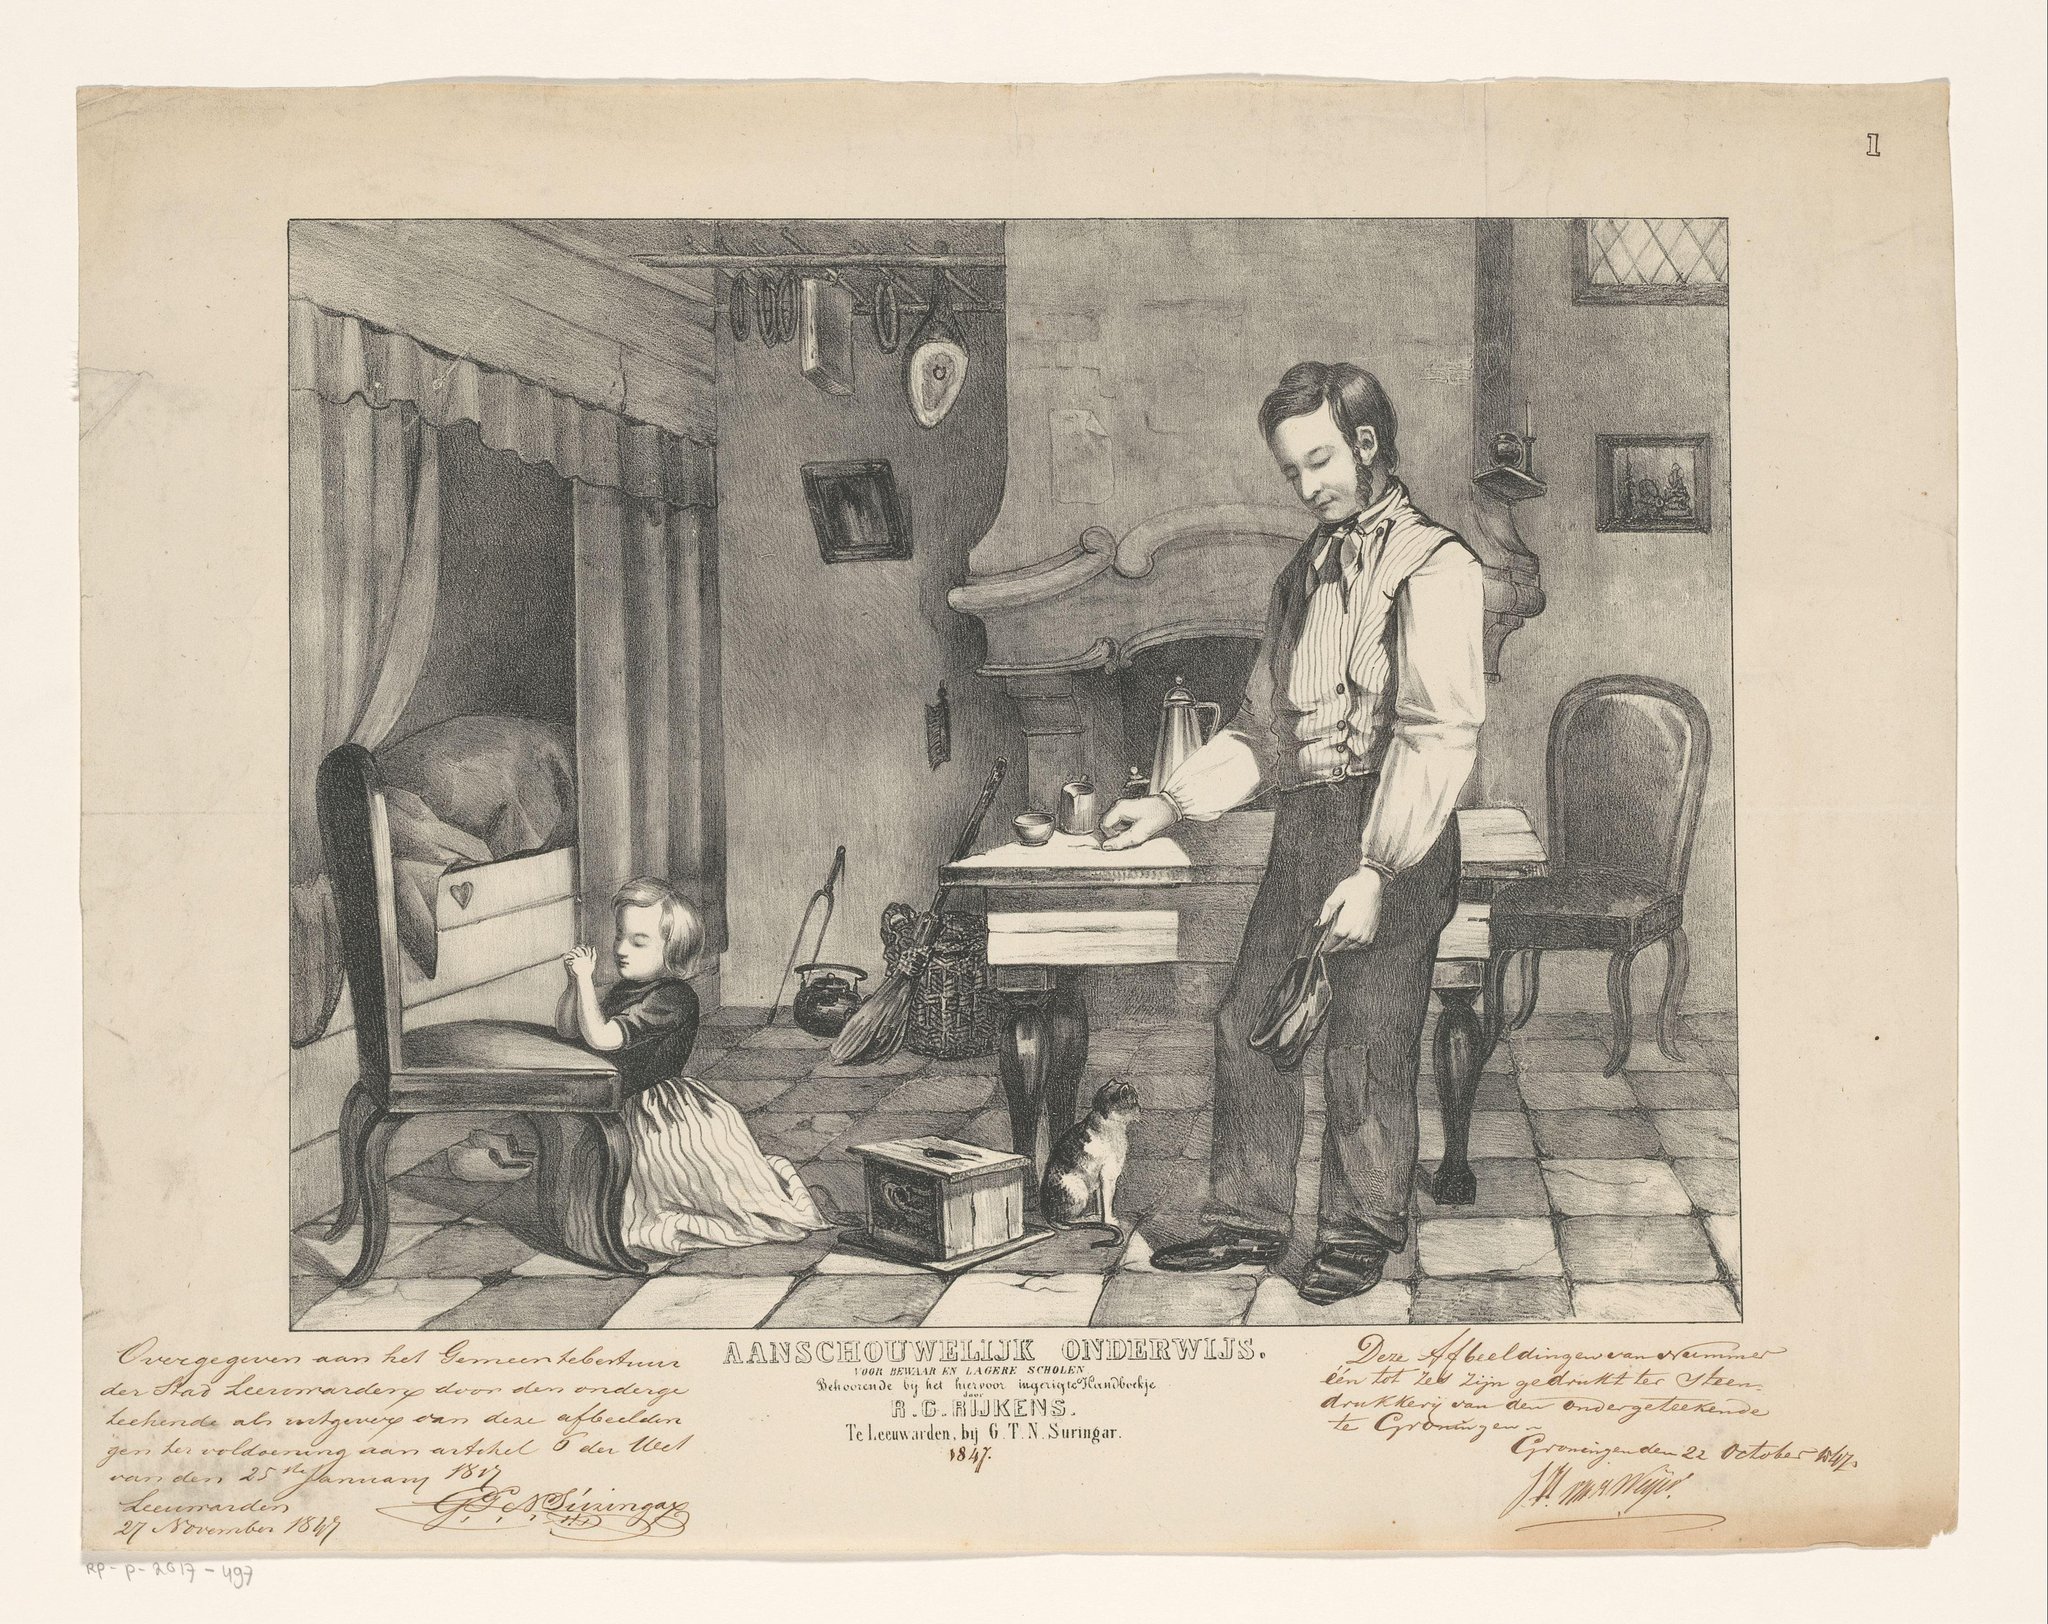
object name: print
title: Aanschouwelijk onderwijs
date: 1847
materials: paper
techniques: lithograph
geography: leeuwarden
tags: father and daughter(s) (family group), (private) prayer; 'oratione', 'preghiere', 'preghiere a dio' (ripa), interior of the house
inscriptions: : ‘Deze afbeeldingen van nummer / één tot zes zijn gedrukt ter steen / drukkerij van den ondergeteekende / te Groningen / Groningen den 22 october 1847 / J.H. van de Weijer’, : ‘Overgegeven aan het gemeentebestuur / der stad Leeuwarden door den onderge / teekende als uitgevers van deze afbeeldin / gen ter voldoening aan artikel 6 der wet / van den 25ste januari 1817 / Leeuwarden 27 November 1847 / GTN Suringar’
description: De dochter zit geknield voor een stoel, de vader heeft zijn pet afgenomen en staat naast de tafel. Beiden hebben hun ogen gesloten. Links een bedstede, achter hen een open haard. Genummerd rechtsboven: 1.